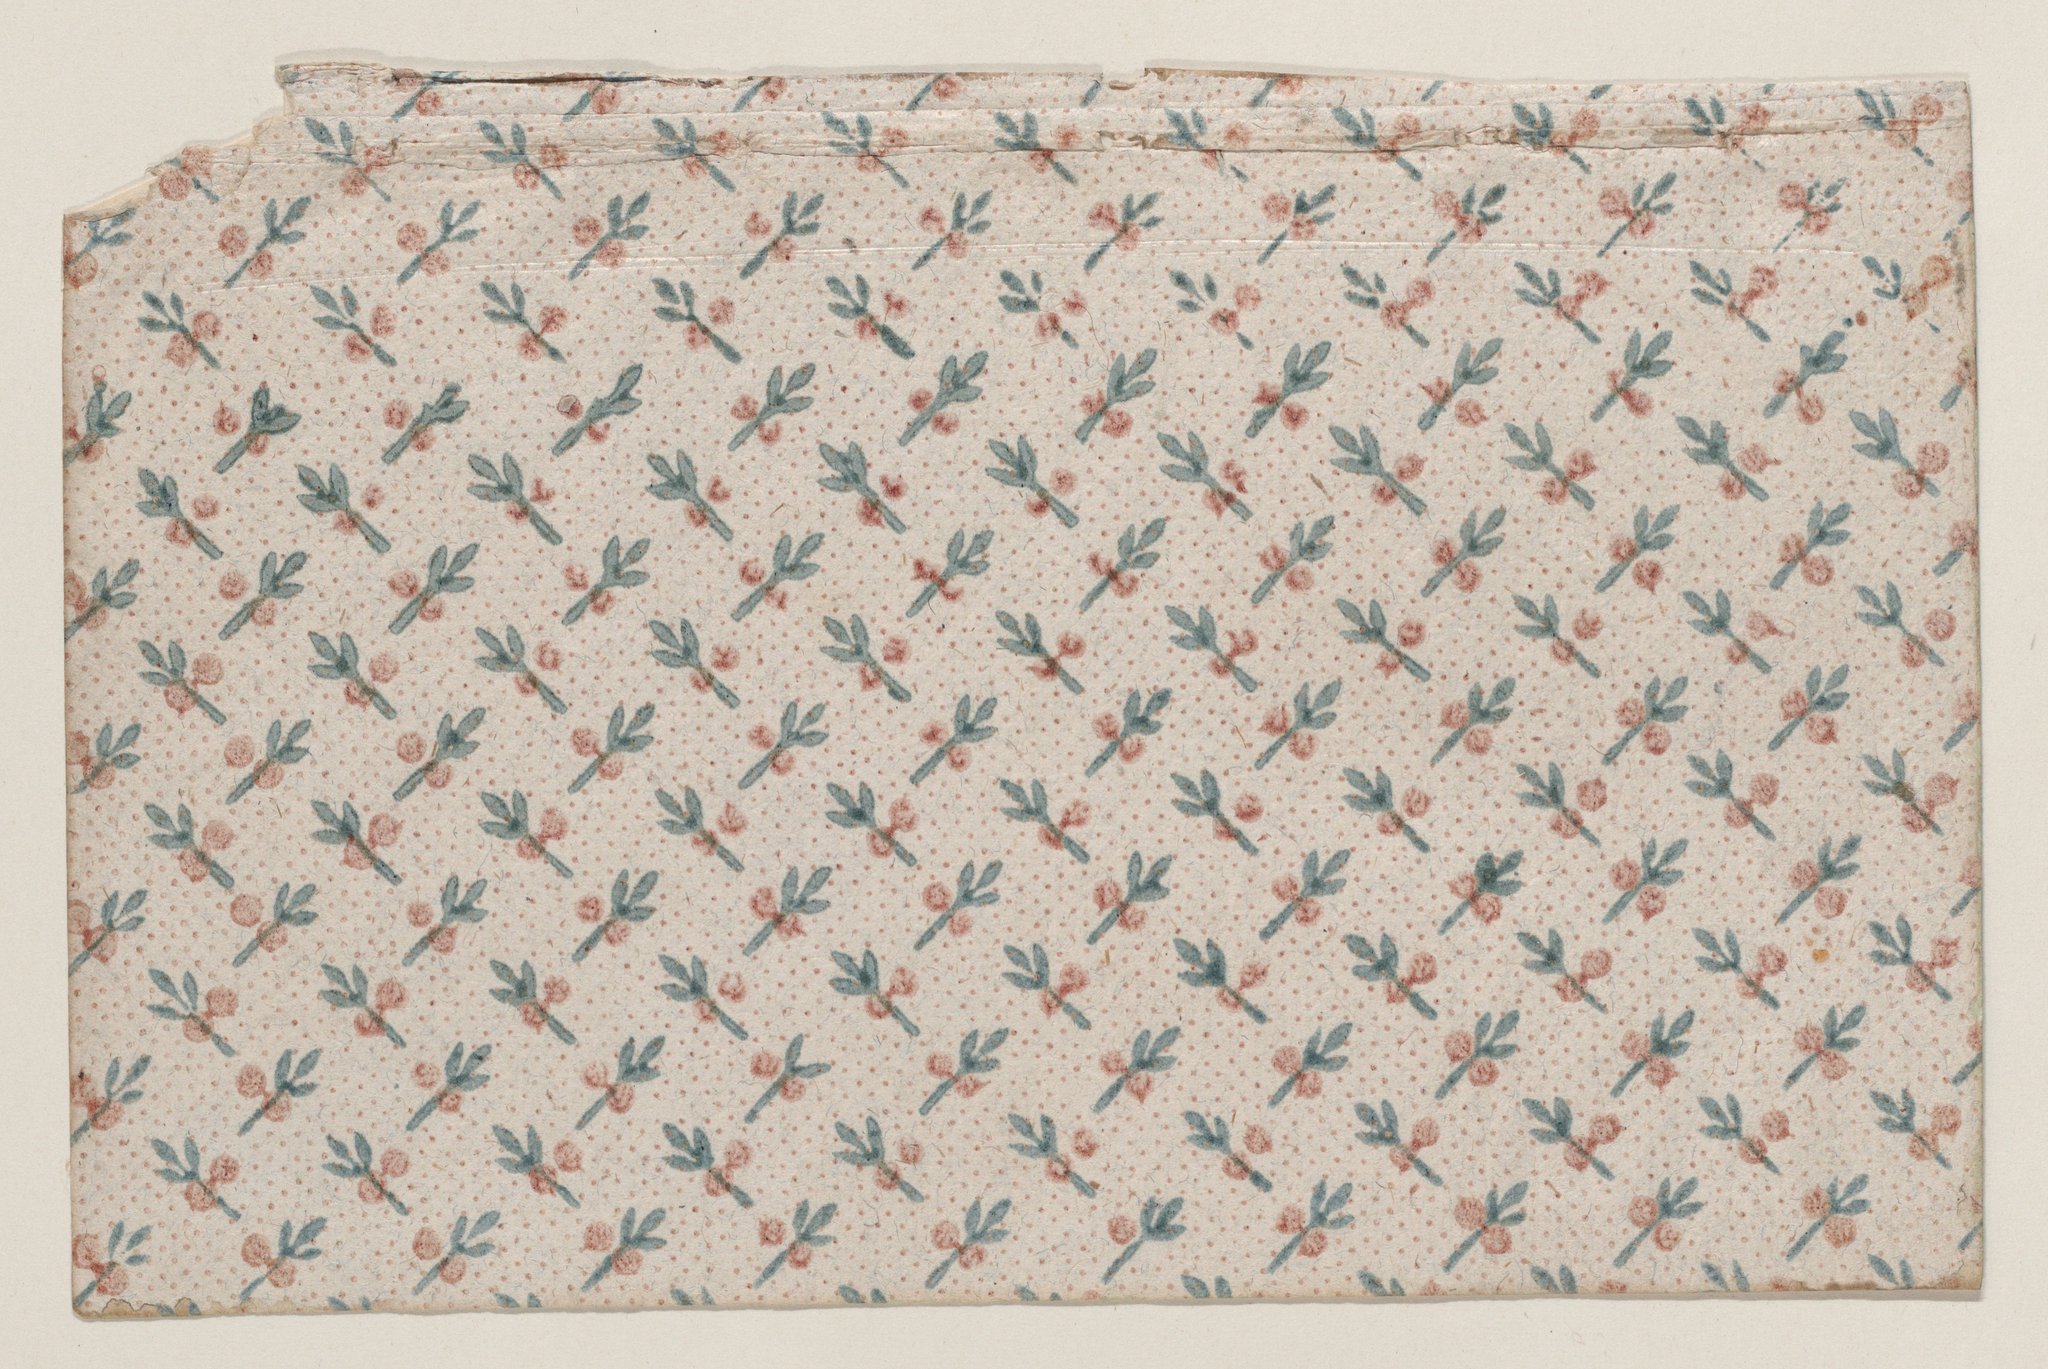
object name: print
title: Sheet with overall floral and dot pattern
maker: Anonymous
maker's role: artist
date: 1801-1900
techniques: relief print